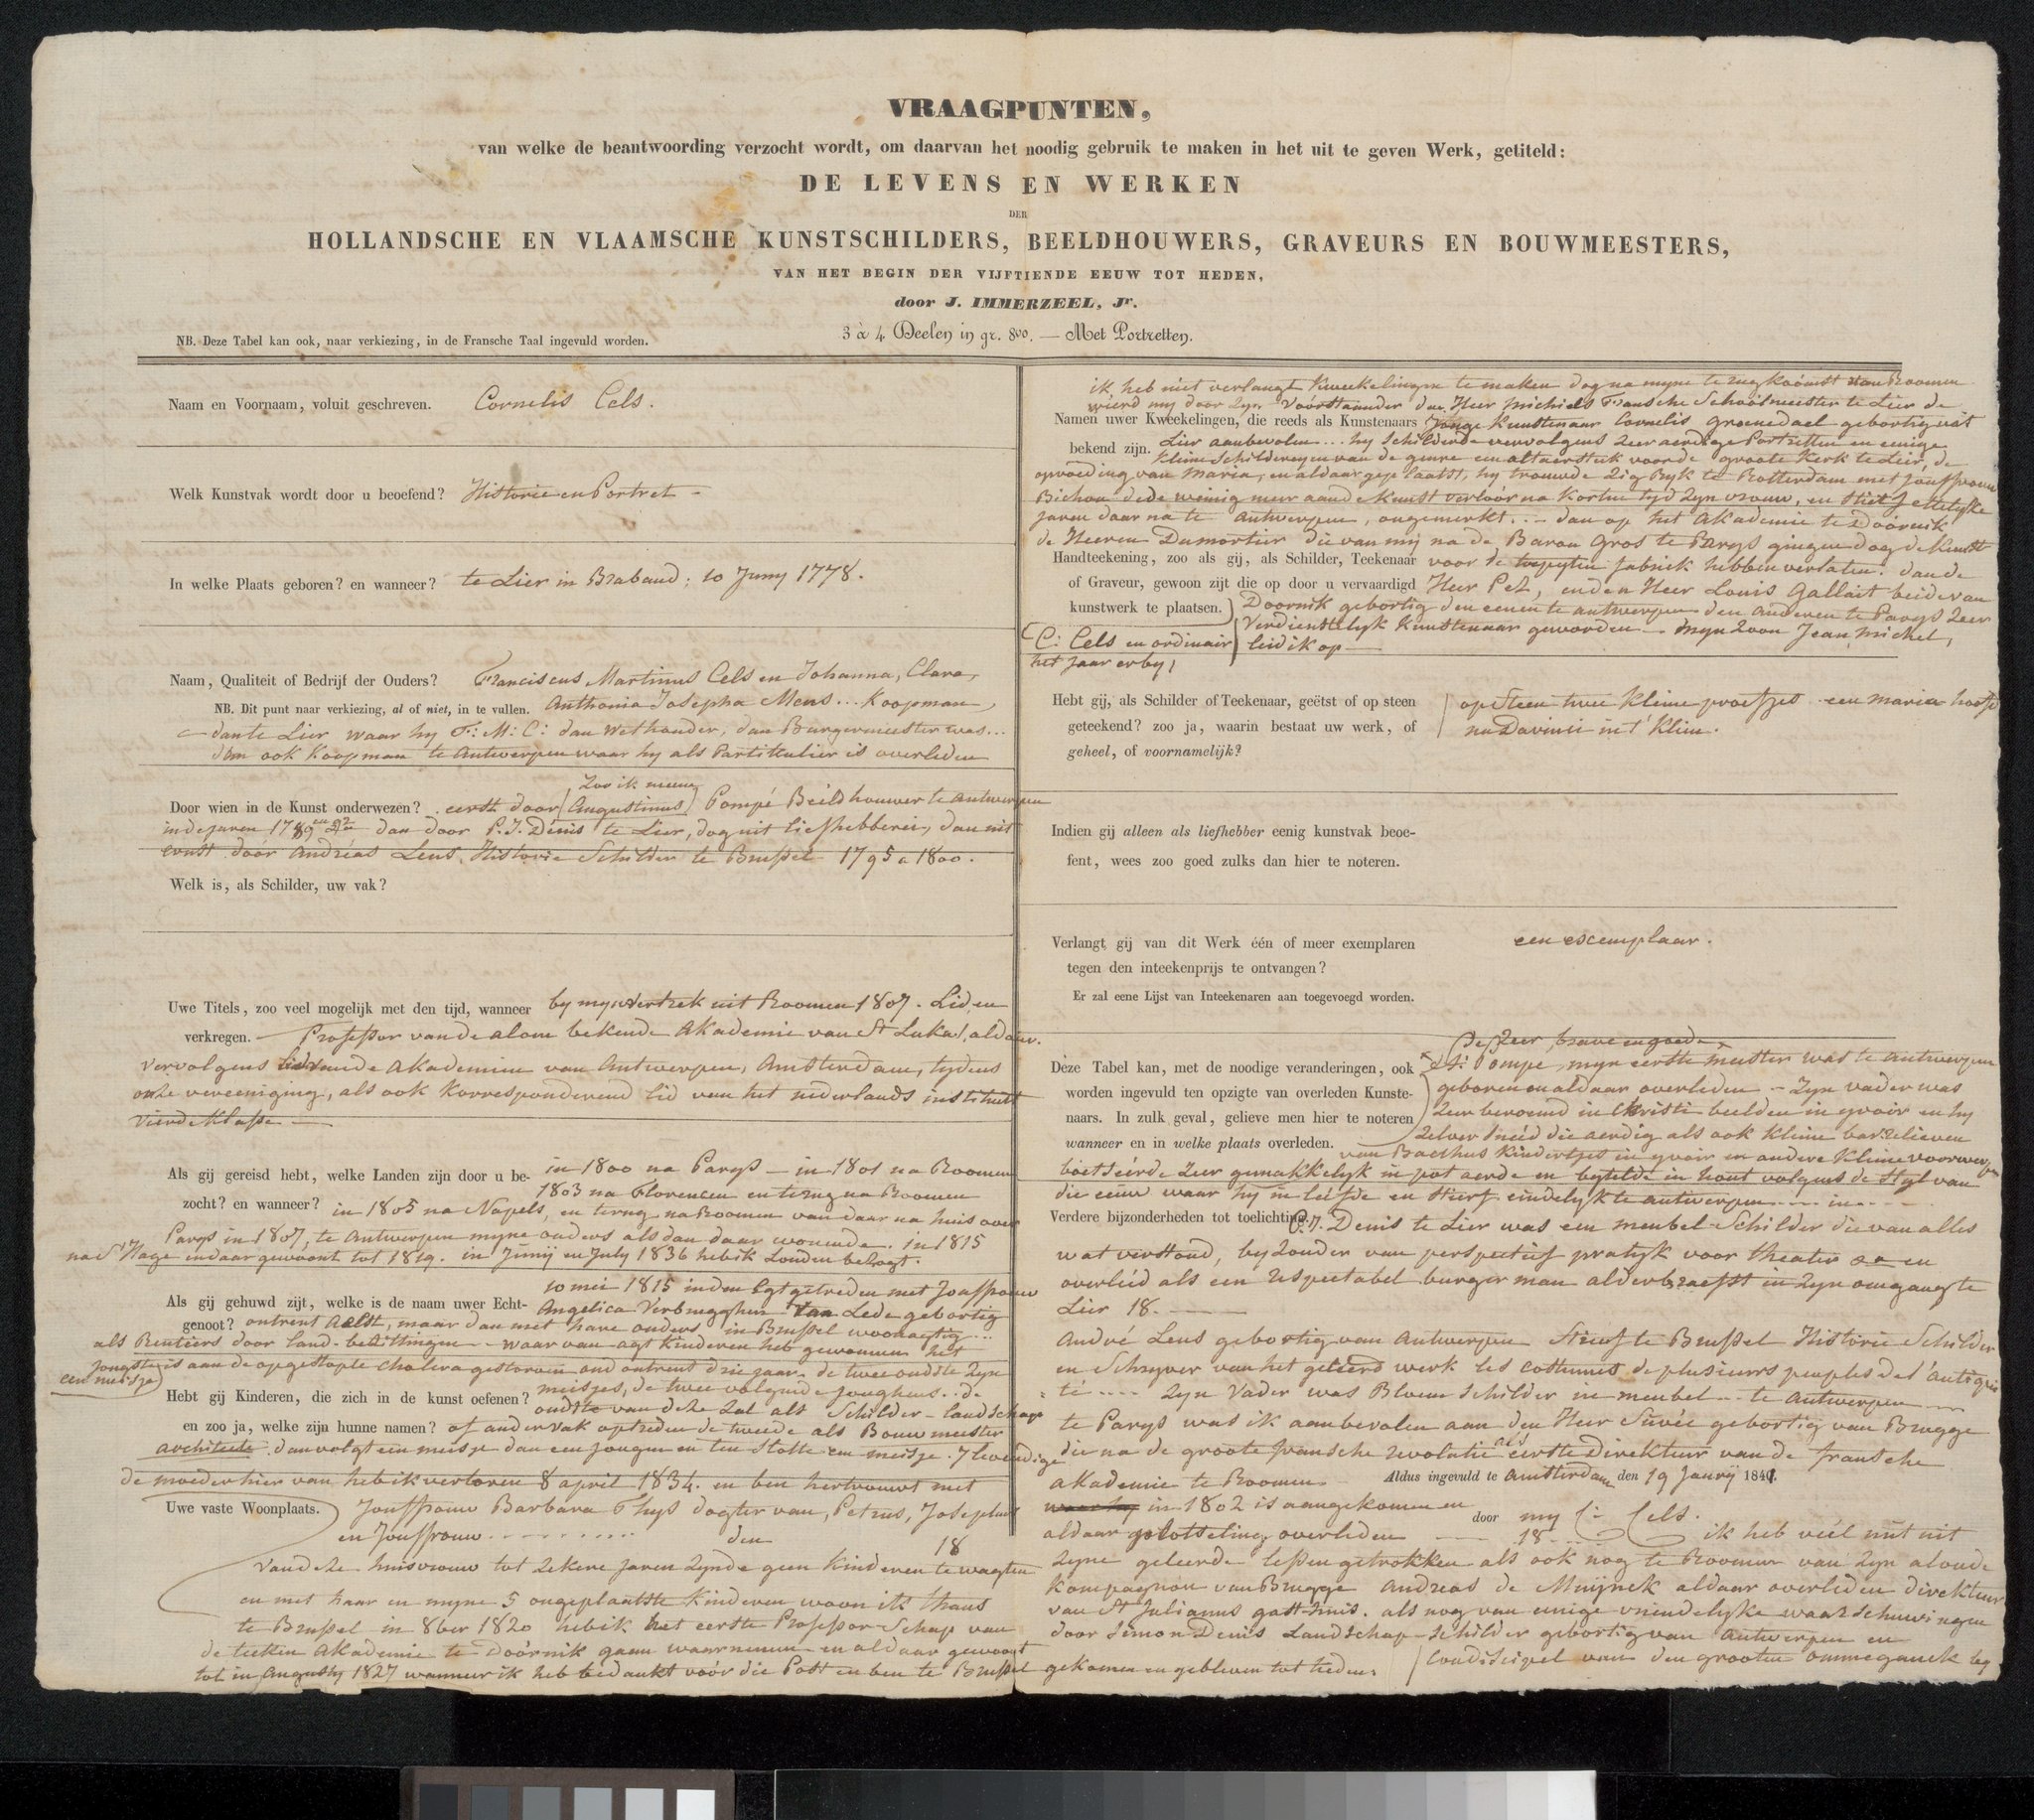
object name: questionnaire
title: Enquêteformulier ingevuld door Cornelis Cels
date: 1841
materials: ink, paper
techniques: pen, printing, writing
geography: amsterdam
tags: cornelis cels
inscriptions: inscription: ‘Vraagpunten,/ van welke de beantwoording verzocht wordt, om daarvan het noodig gebruik te maken in het uit te geven Werk, getiteld: De levens en werken/ der Hollandsche en Vlaamsche kunstschilders, beeldhouwers,/ graveurs en bouwmeesters, van het begin der vijftiende eeuw tot heden/ door J. Immerzeel, Jr.’, watermark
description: Opgenomen in: Immerzeel, J. Jr., De levens en werken der Hollandsche en Vlaamsche kunstschilders, beeldhouwers, graveurs en bouwmeesters, van het begin der vijftiende eeuw tot heden, Amsterdam: J.C. van Kesteren, 1842-1843.